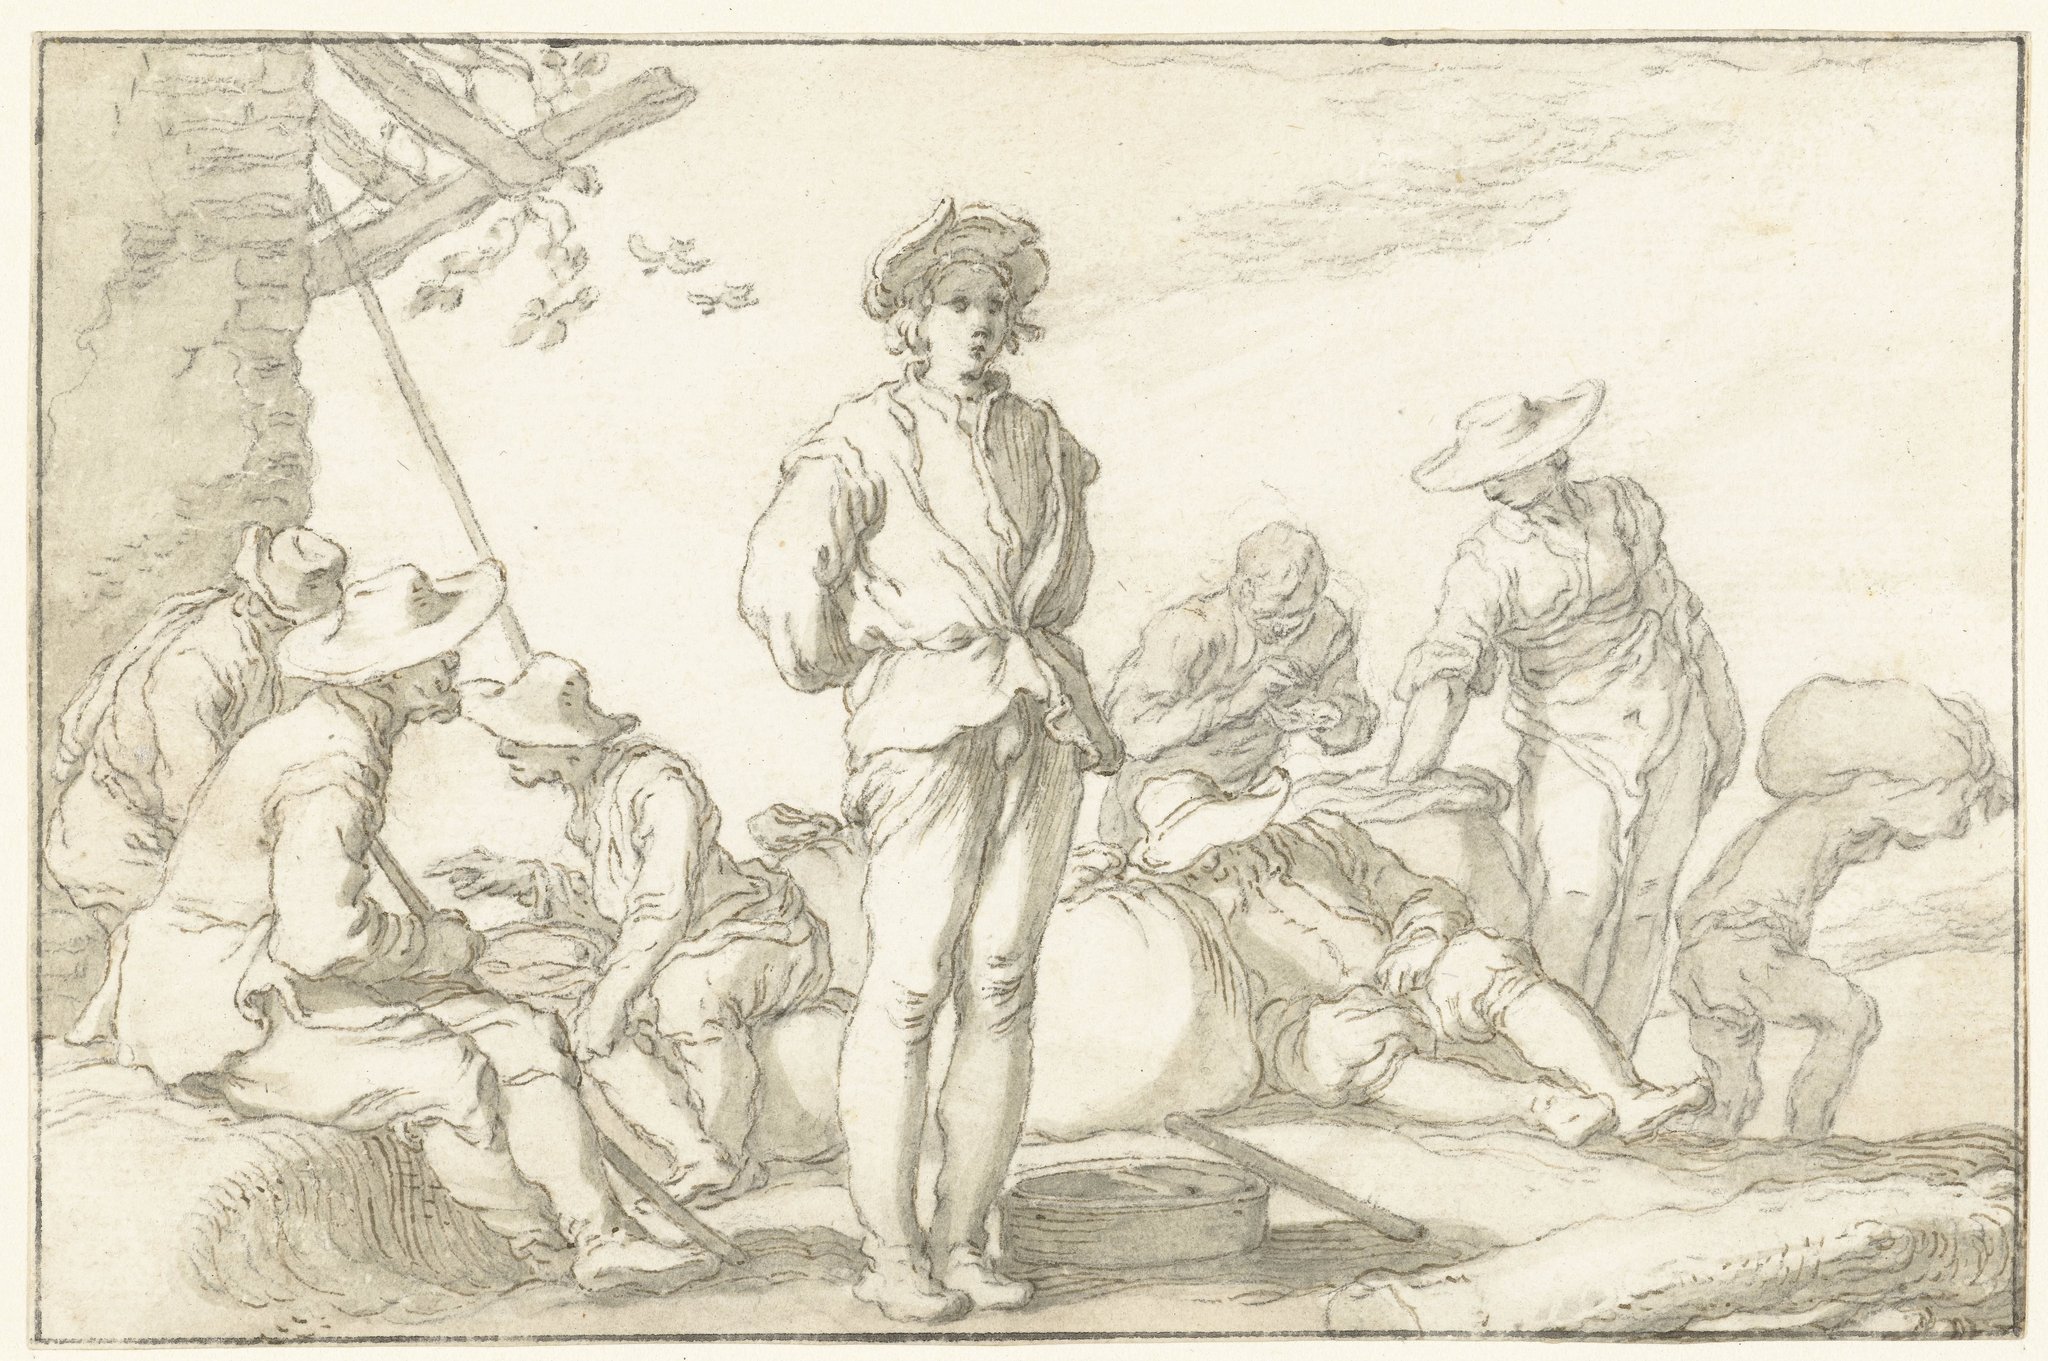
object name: drawing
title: September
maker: abraham bloemaert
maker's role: draughtsman, painter, print maker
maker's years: 1566-1651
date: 1574-1651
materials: chalk, ink, paper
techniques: brush, pen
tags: harvest, september and its 'labours'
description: Het verzamelen van de graanoogst. Ontwerp voor een prent.